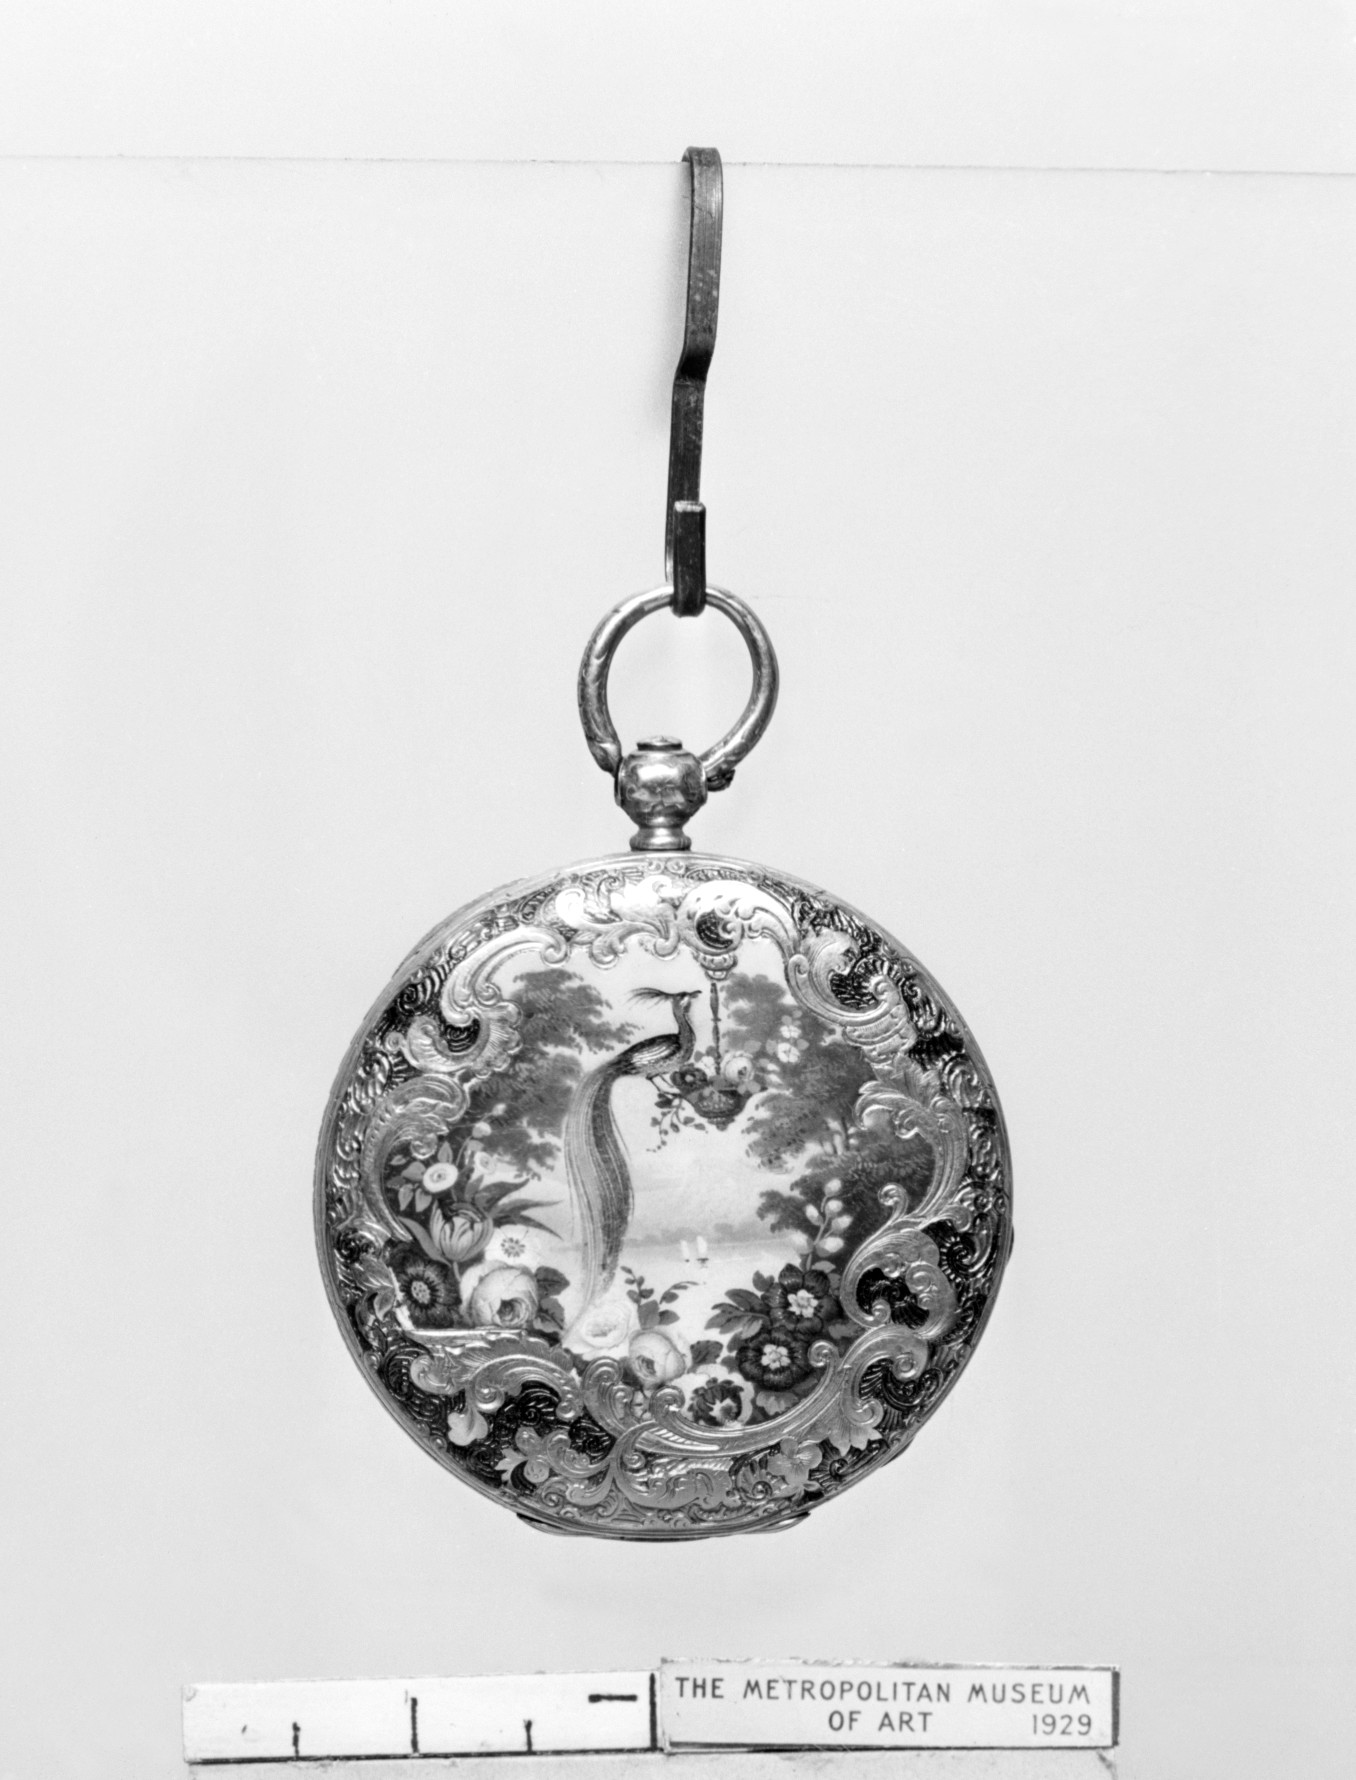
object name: watch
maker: thury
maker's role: maker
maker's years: 1775-1875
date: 1801-1833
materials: enamel, gold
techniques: painting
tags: peacocks